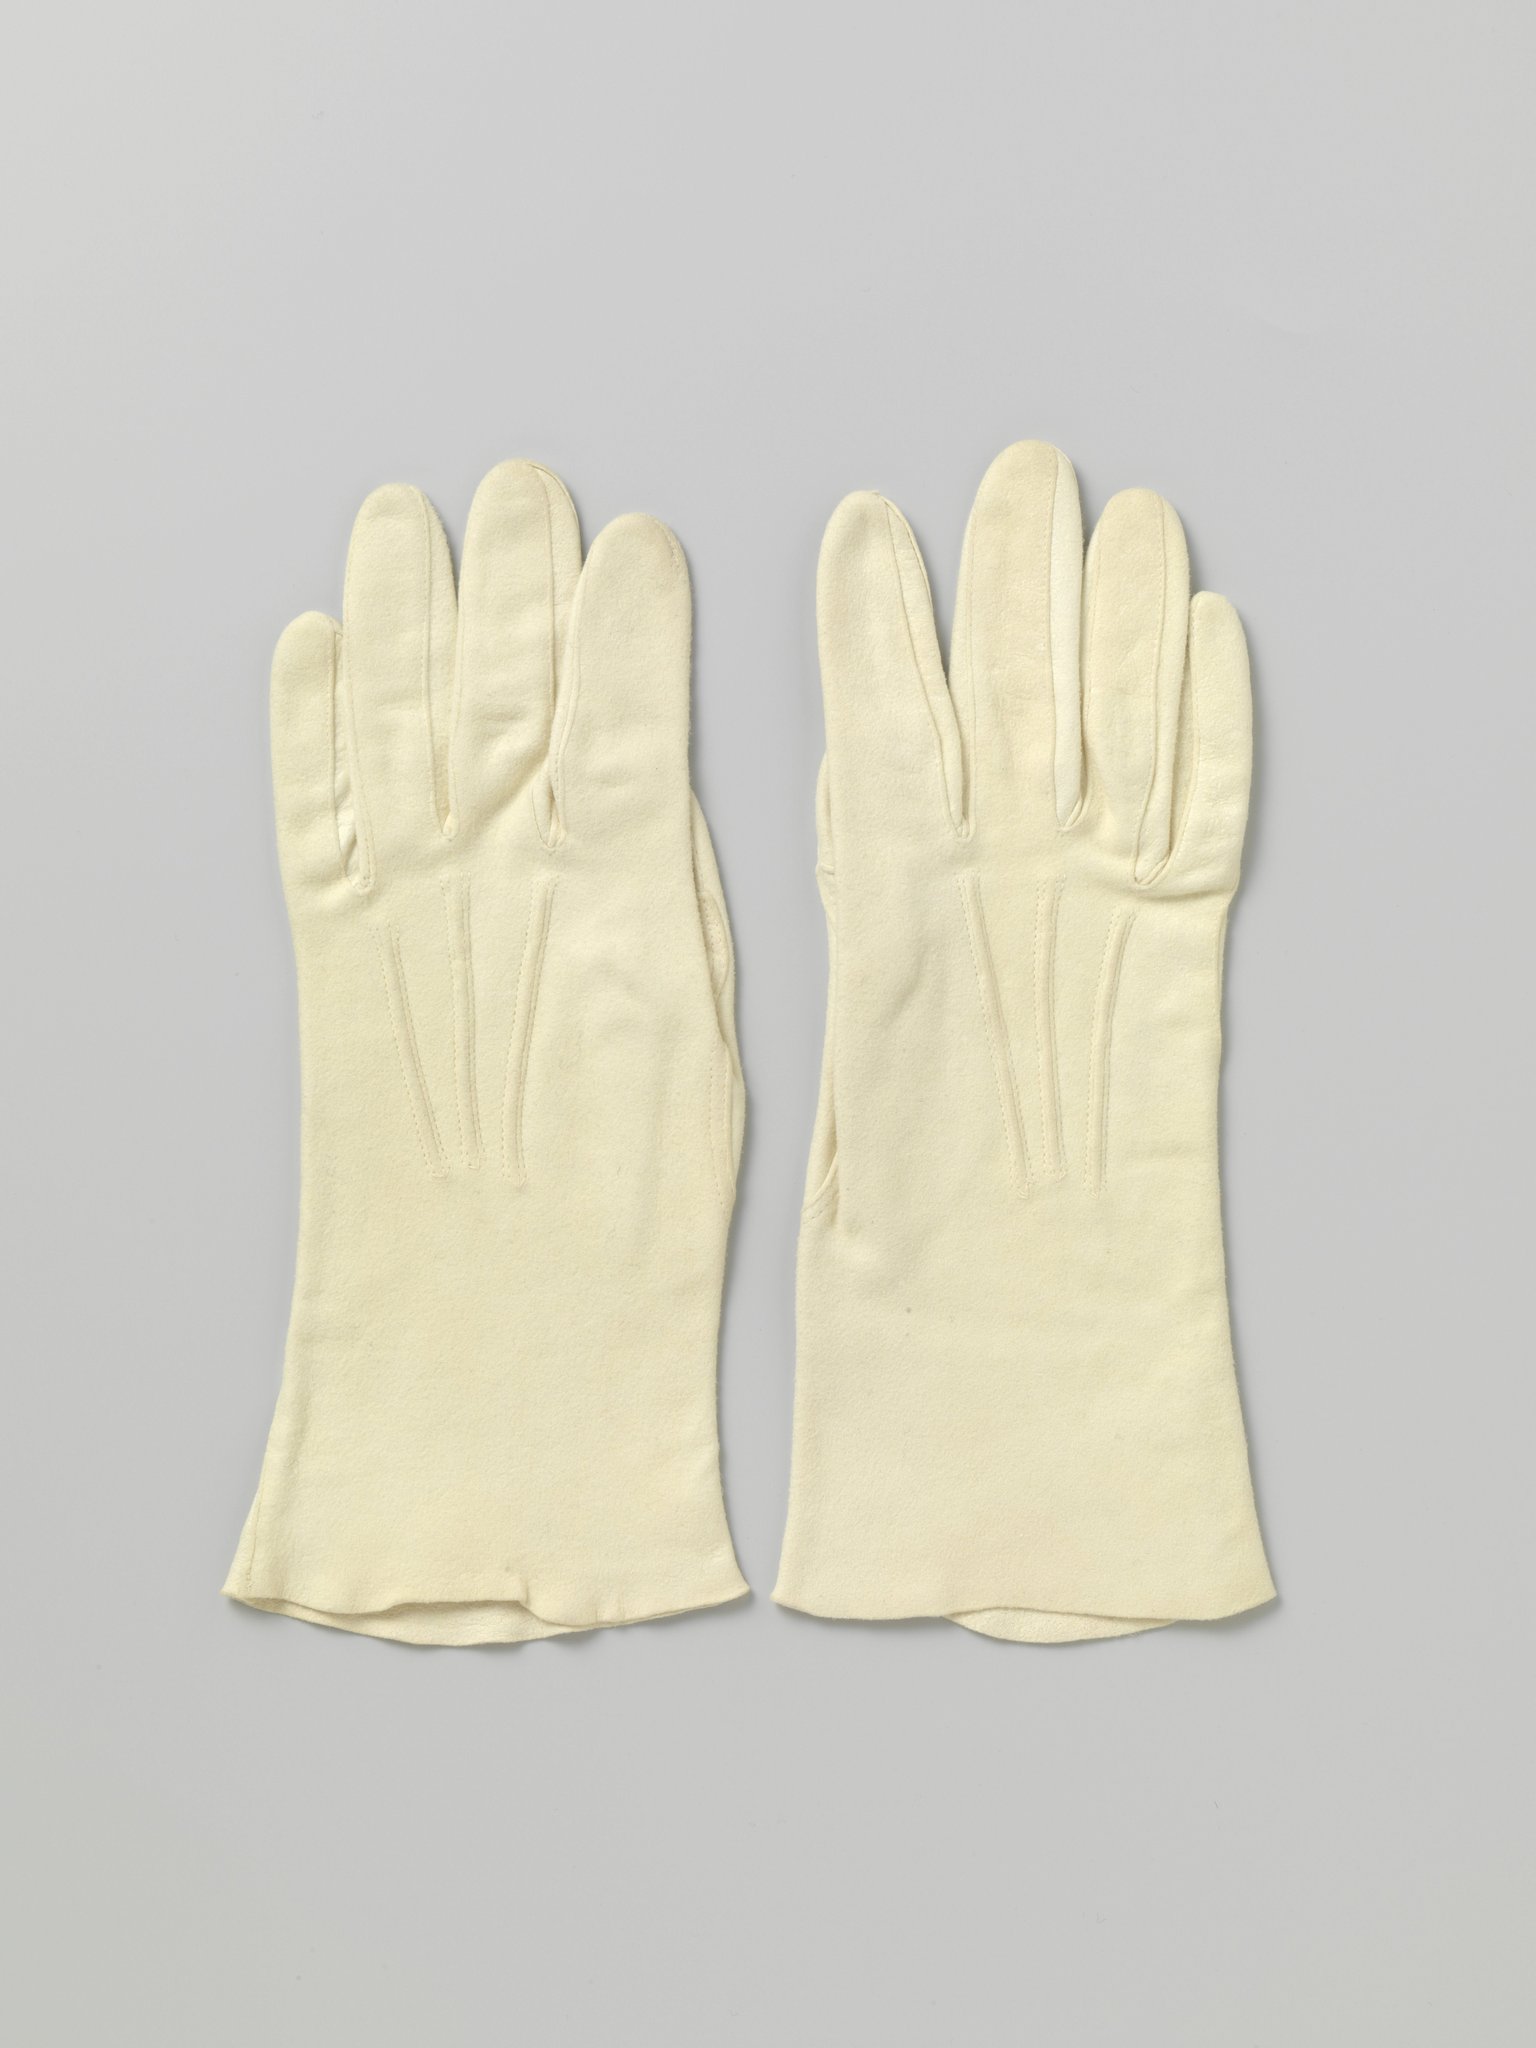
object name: glove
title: Handschoen van cremekleurig vilt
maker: Anonymous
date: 1900-1950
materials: felt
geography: netherlands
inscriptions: stamp: ‘tekst’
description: Rechter handschoen van cremekleurig vilt. Op de rug versierd met drie gestikte lijnen.